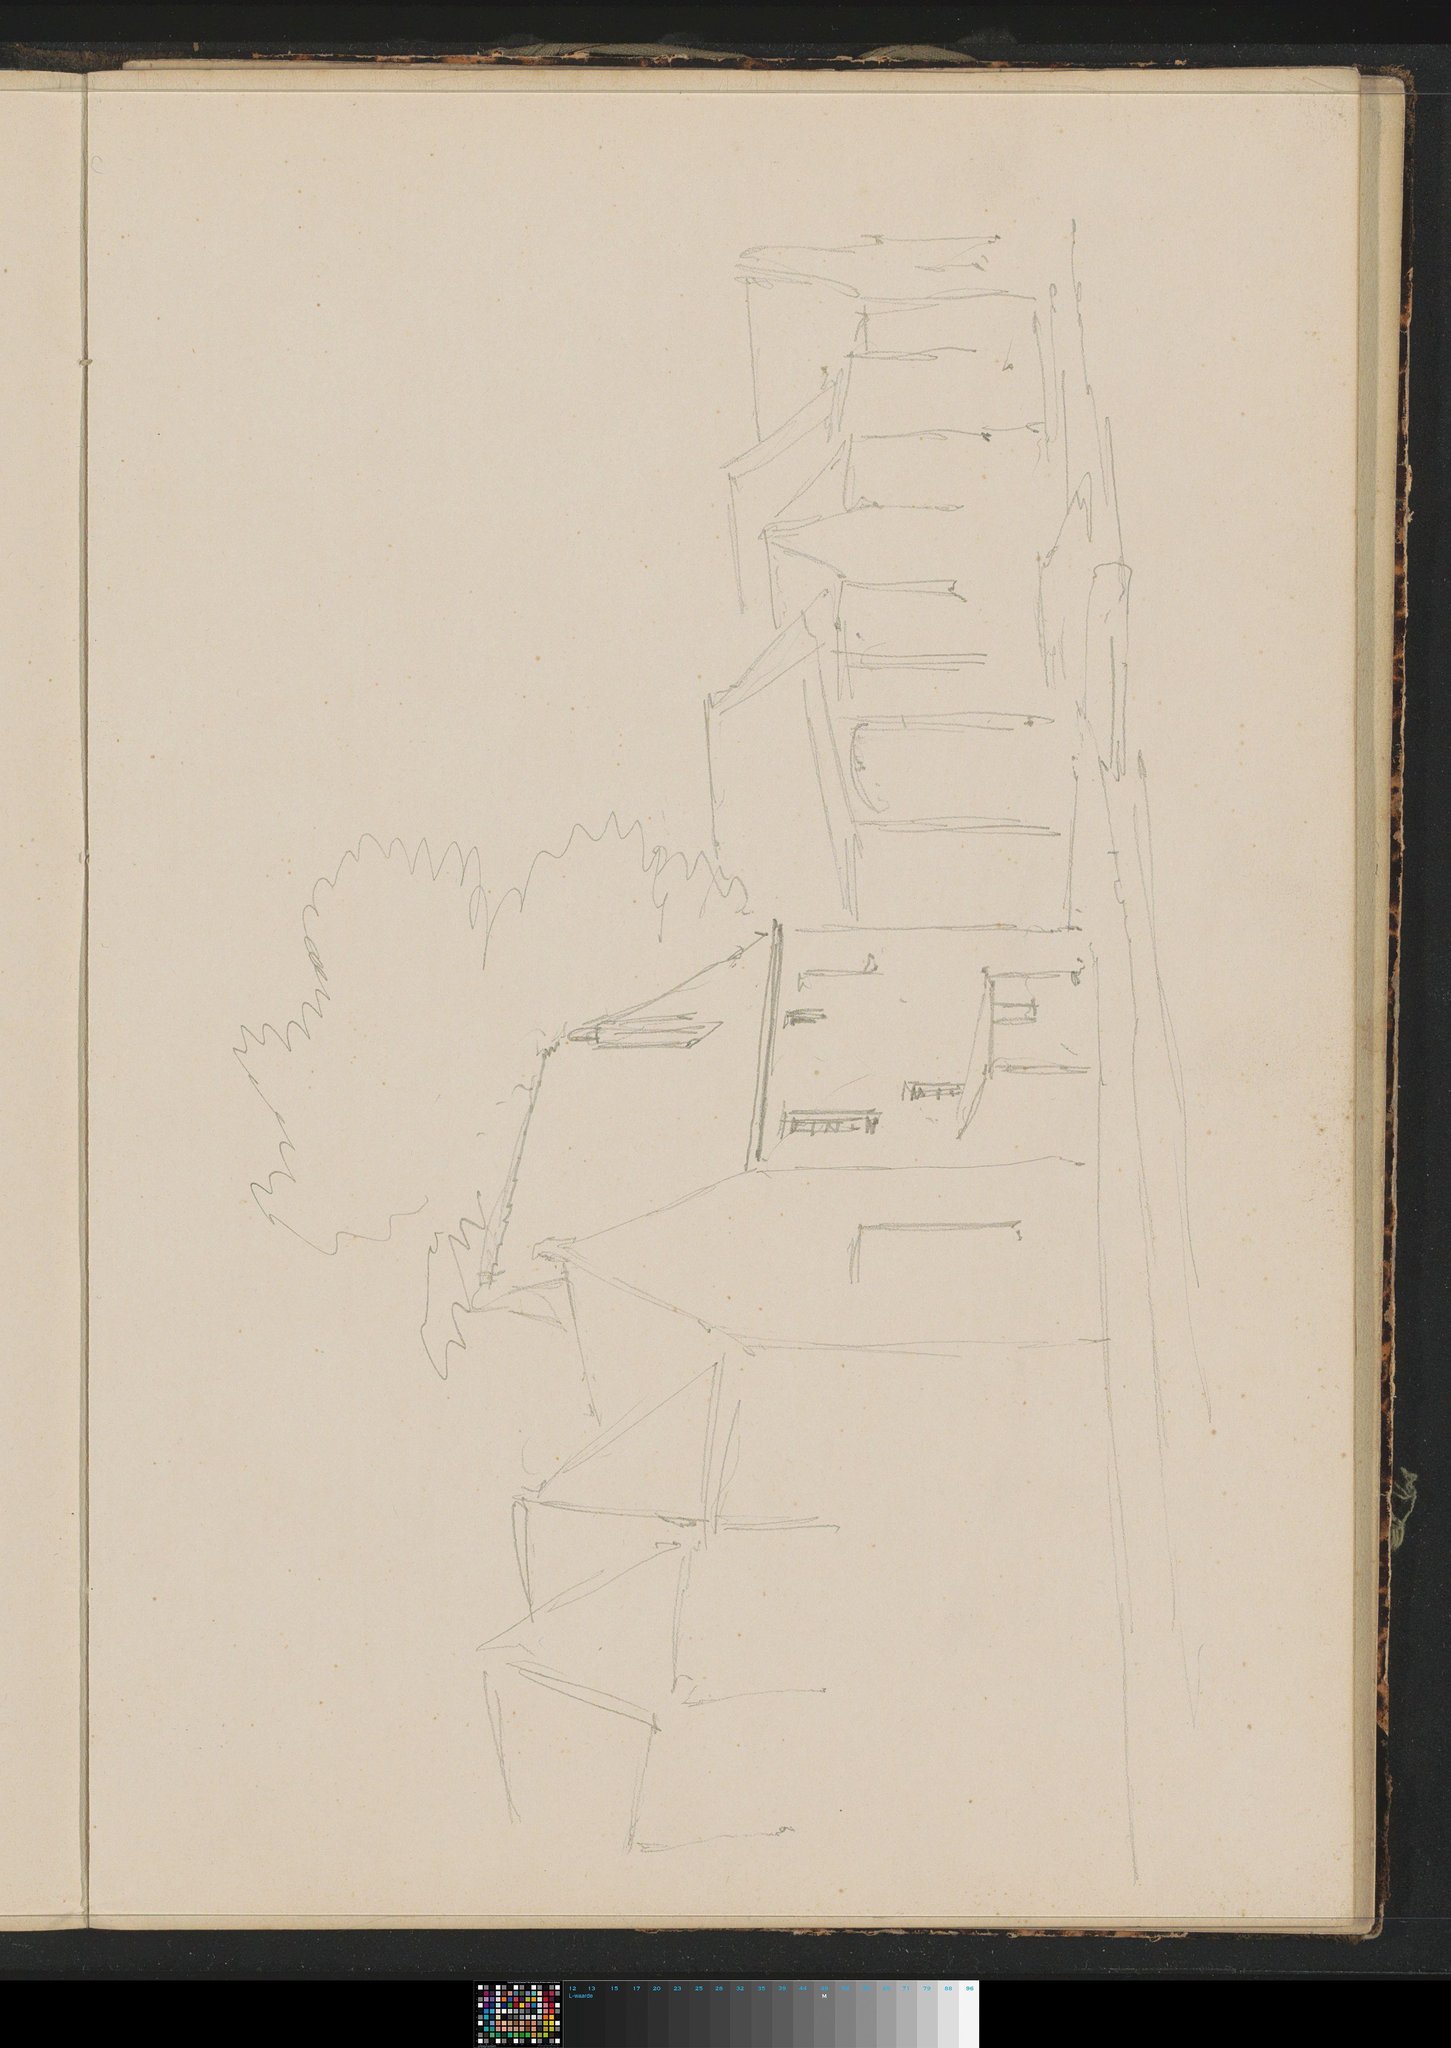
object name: sketchbook leaf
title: Rijtjeshuizen aan een straat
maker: willem koekkoek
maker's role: draughtsman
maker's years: 1839-1895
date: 1888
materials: paper, pencil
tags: the usual house or row of houses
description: Blad 5 recto uit een schetsboek met 24 bladen.